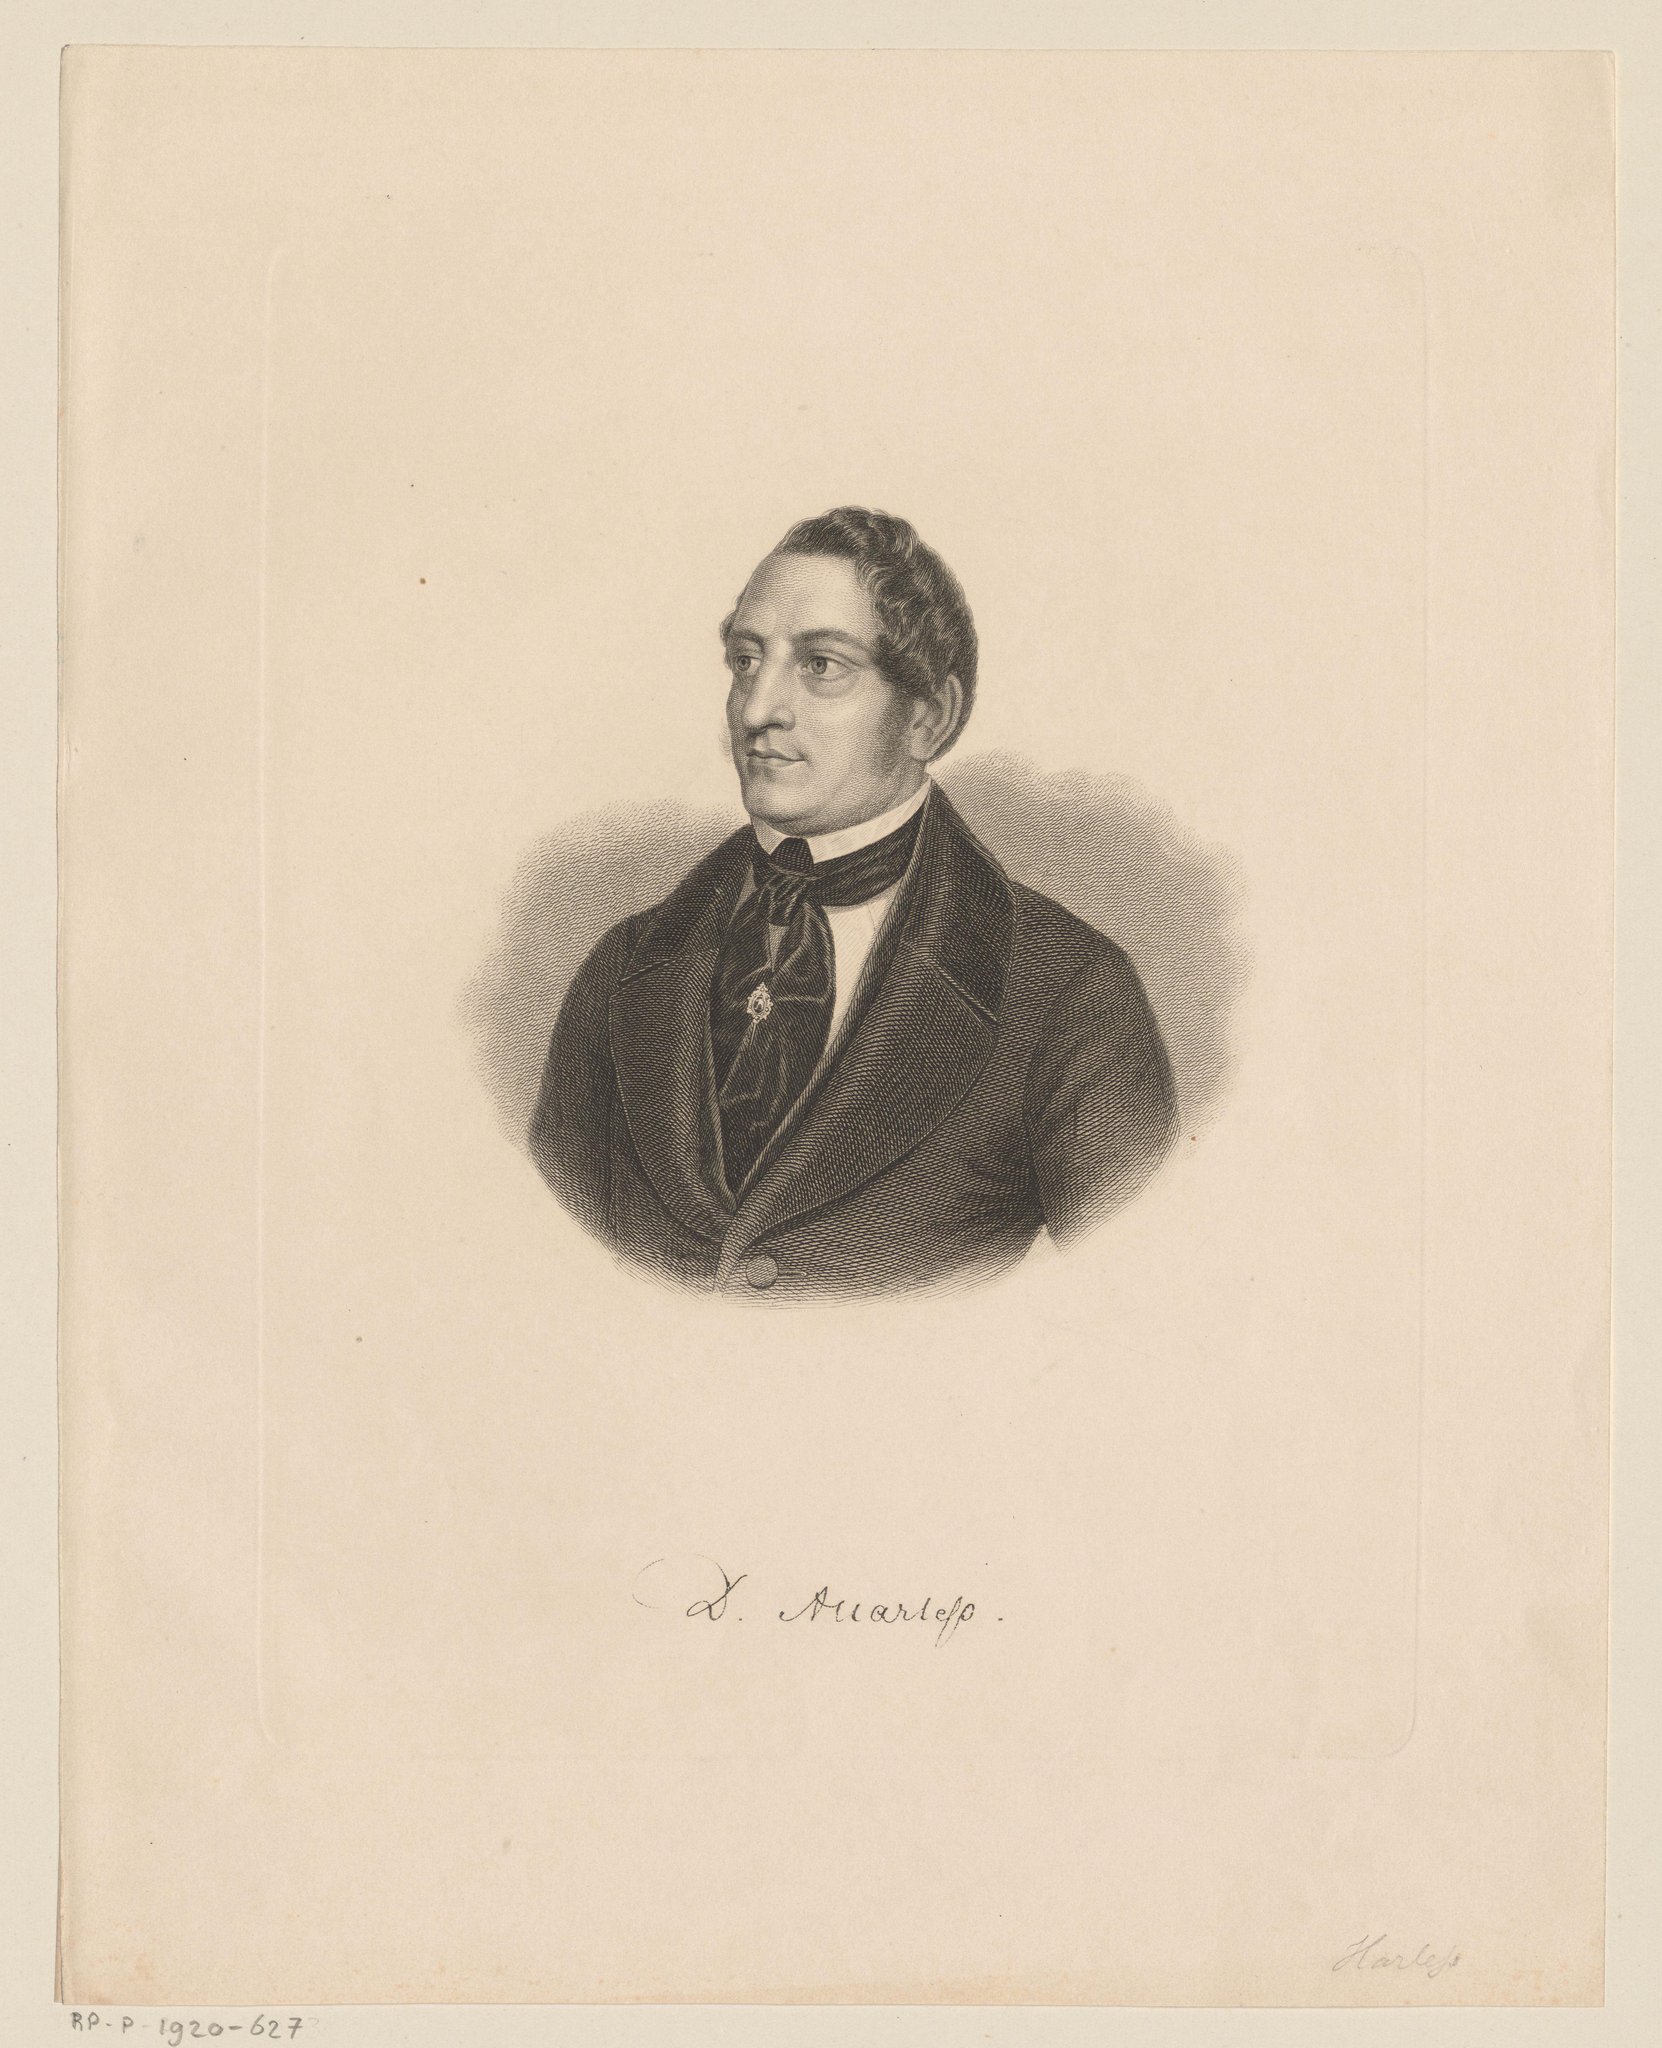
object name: print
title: Portret van Gottlieb Christoph Adolf von Harless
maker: Anonymous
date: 1836-1874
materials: paper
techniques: engraving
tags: theologian, historical persons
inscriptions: collector's mark: Lugt 2228